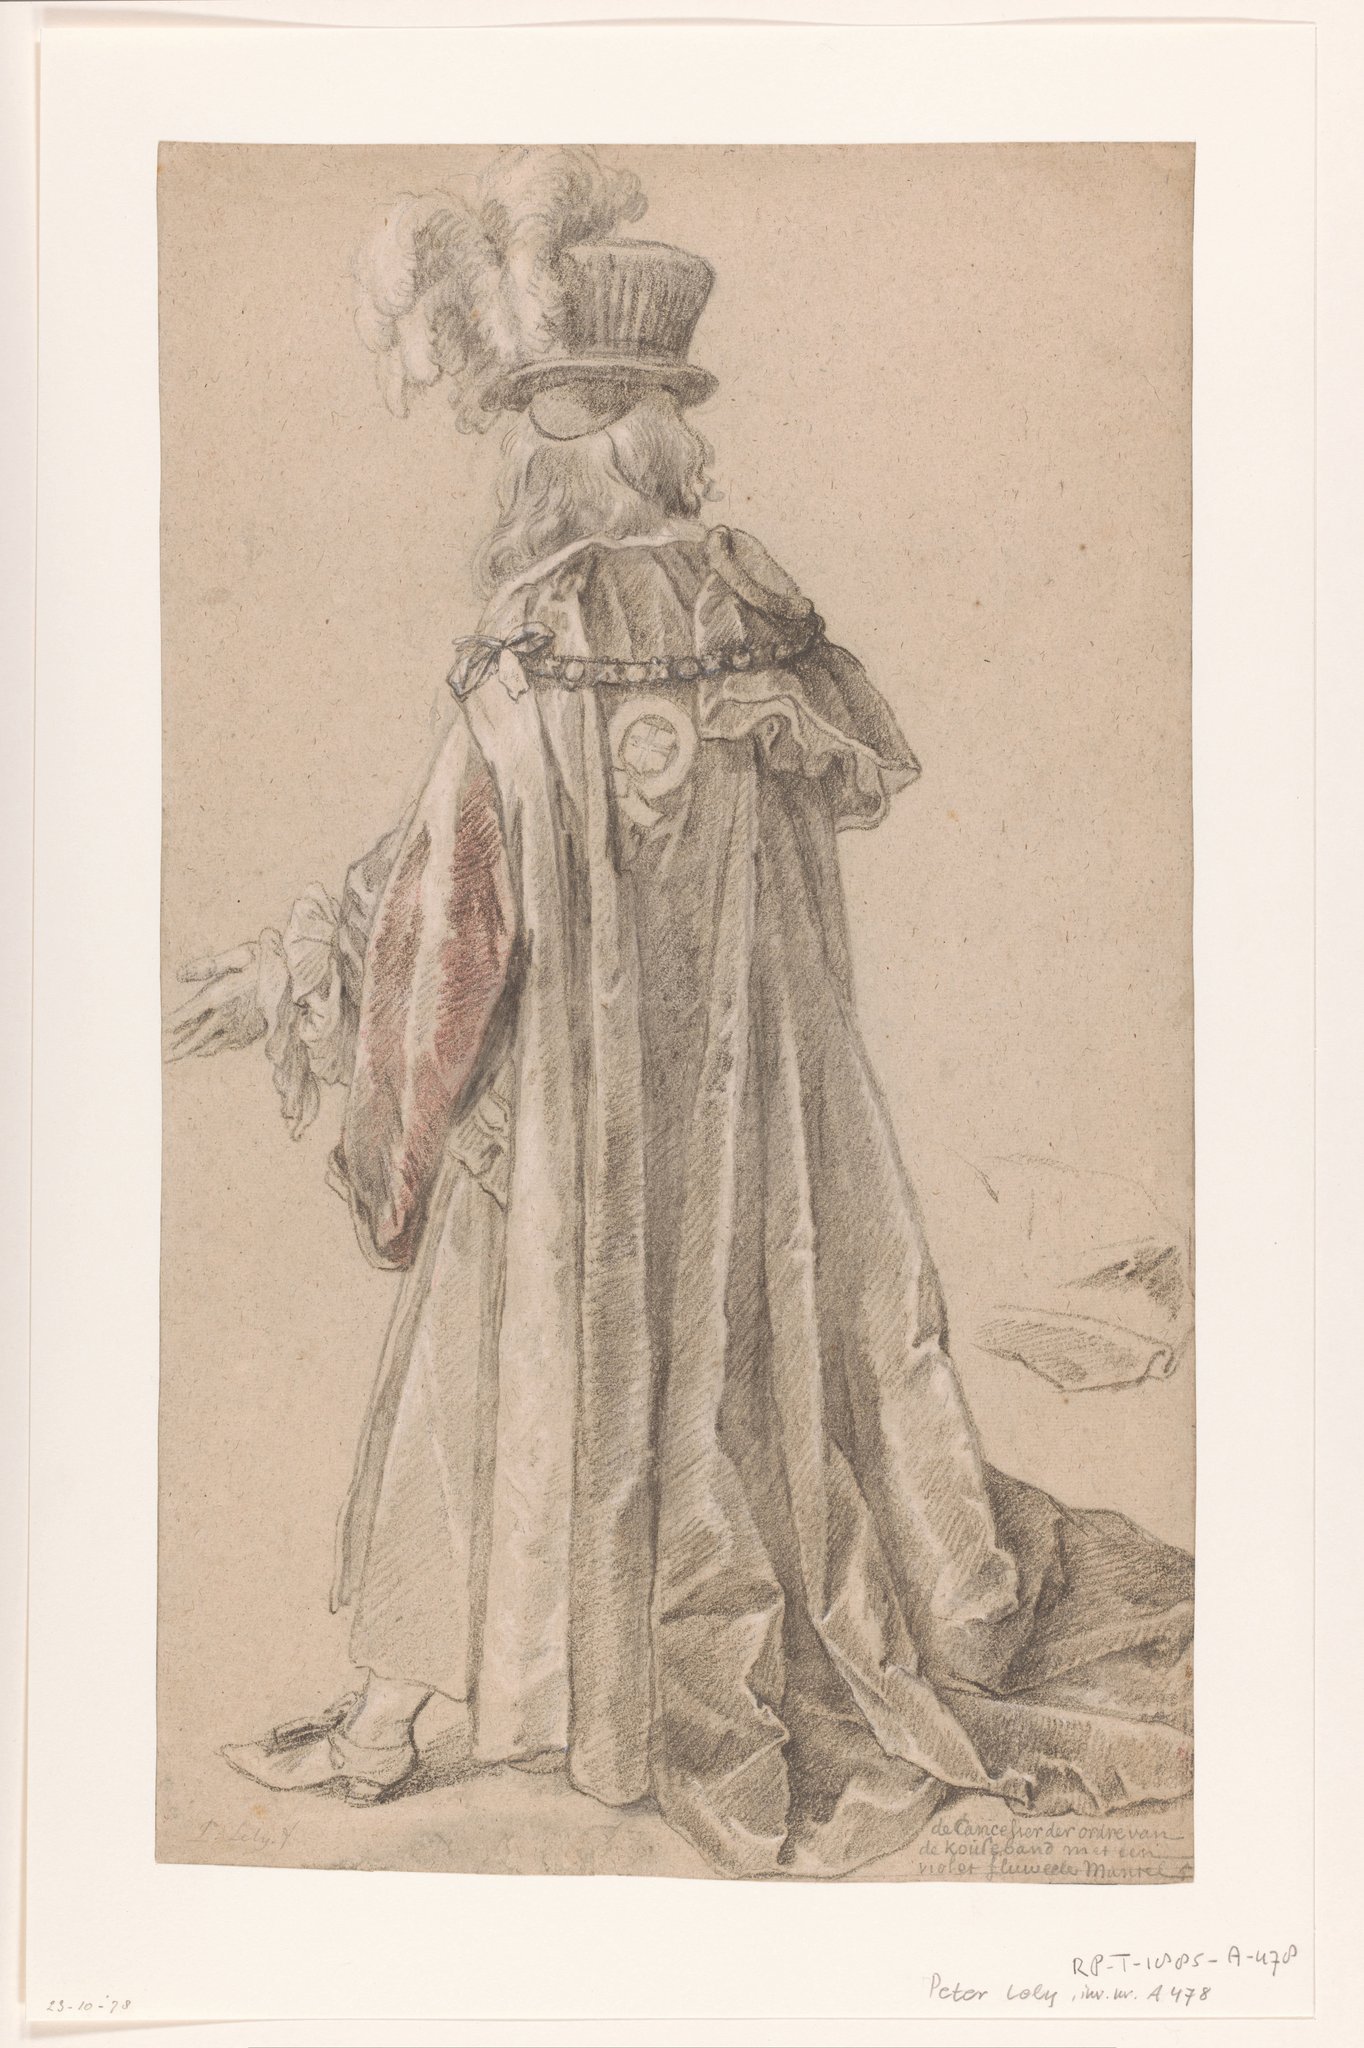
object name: drawing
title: Ridder van de Orde van de Kousenband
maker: peter lely (sir)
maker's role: draughtsman, painter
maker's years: 1618-1680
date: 1663-1667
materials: chalk, charcoal, graphite, paper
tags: knighthood order (garter), walking